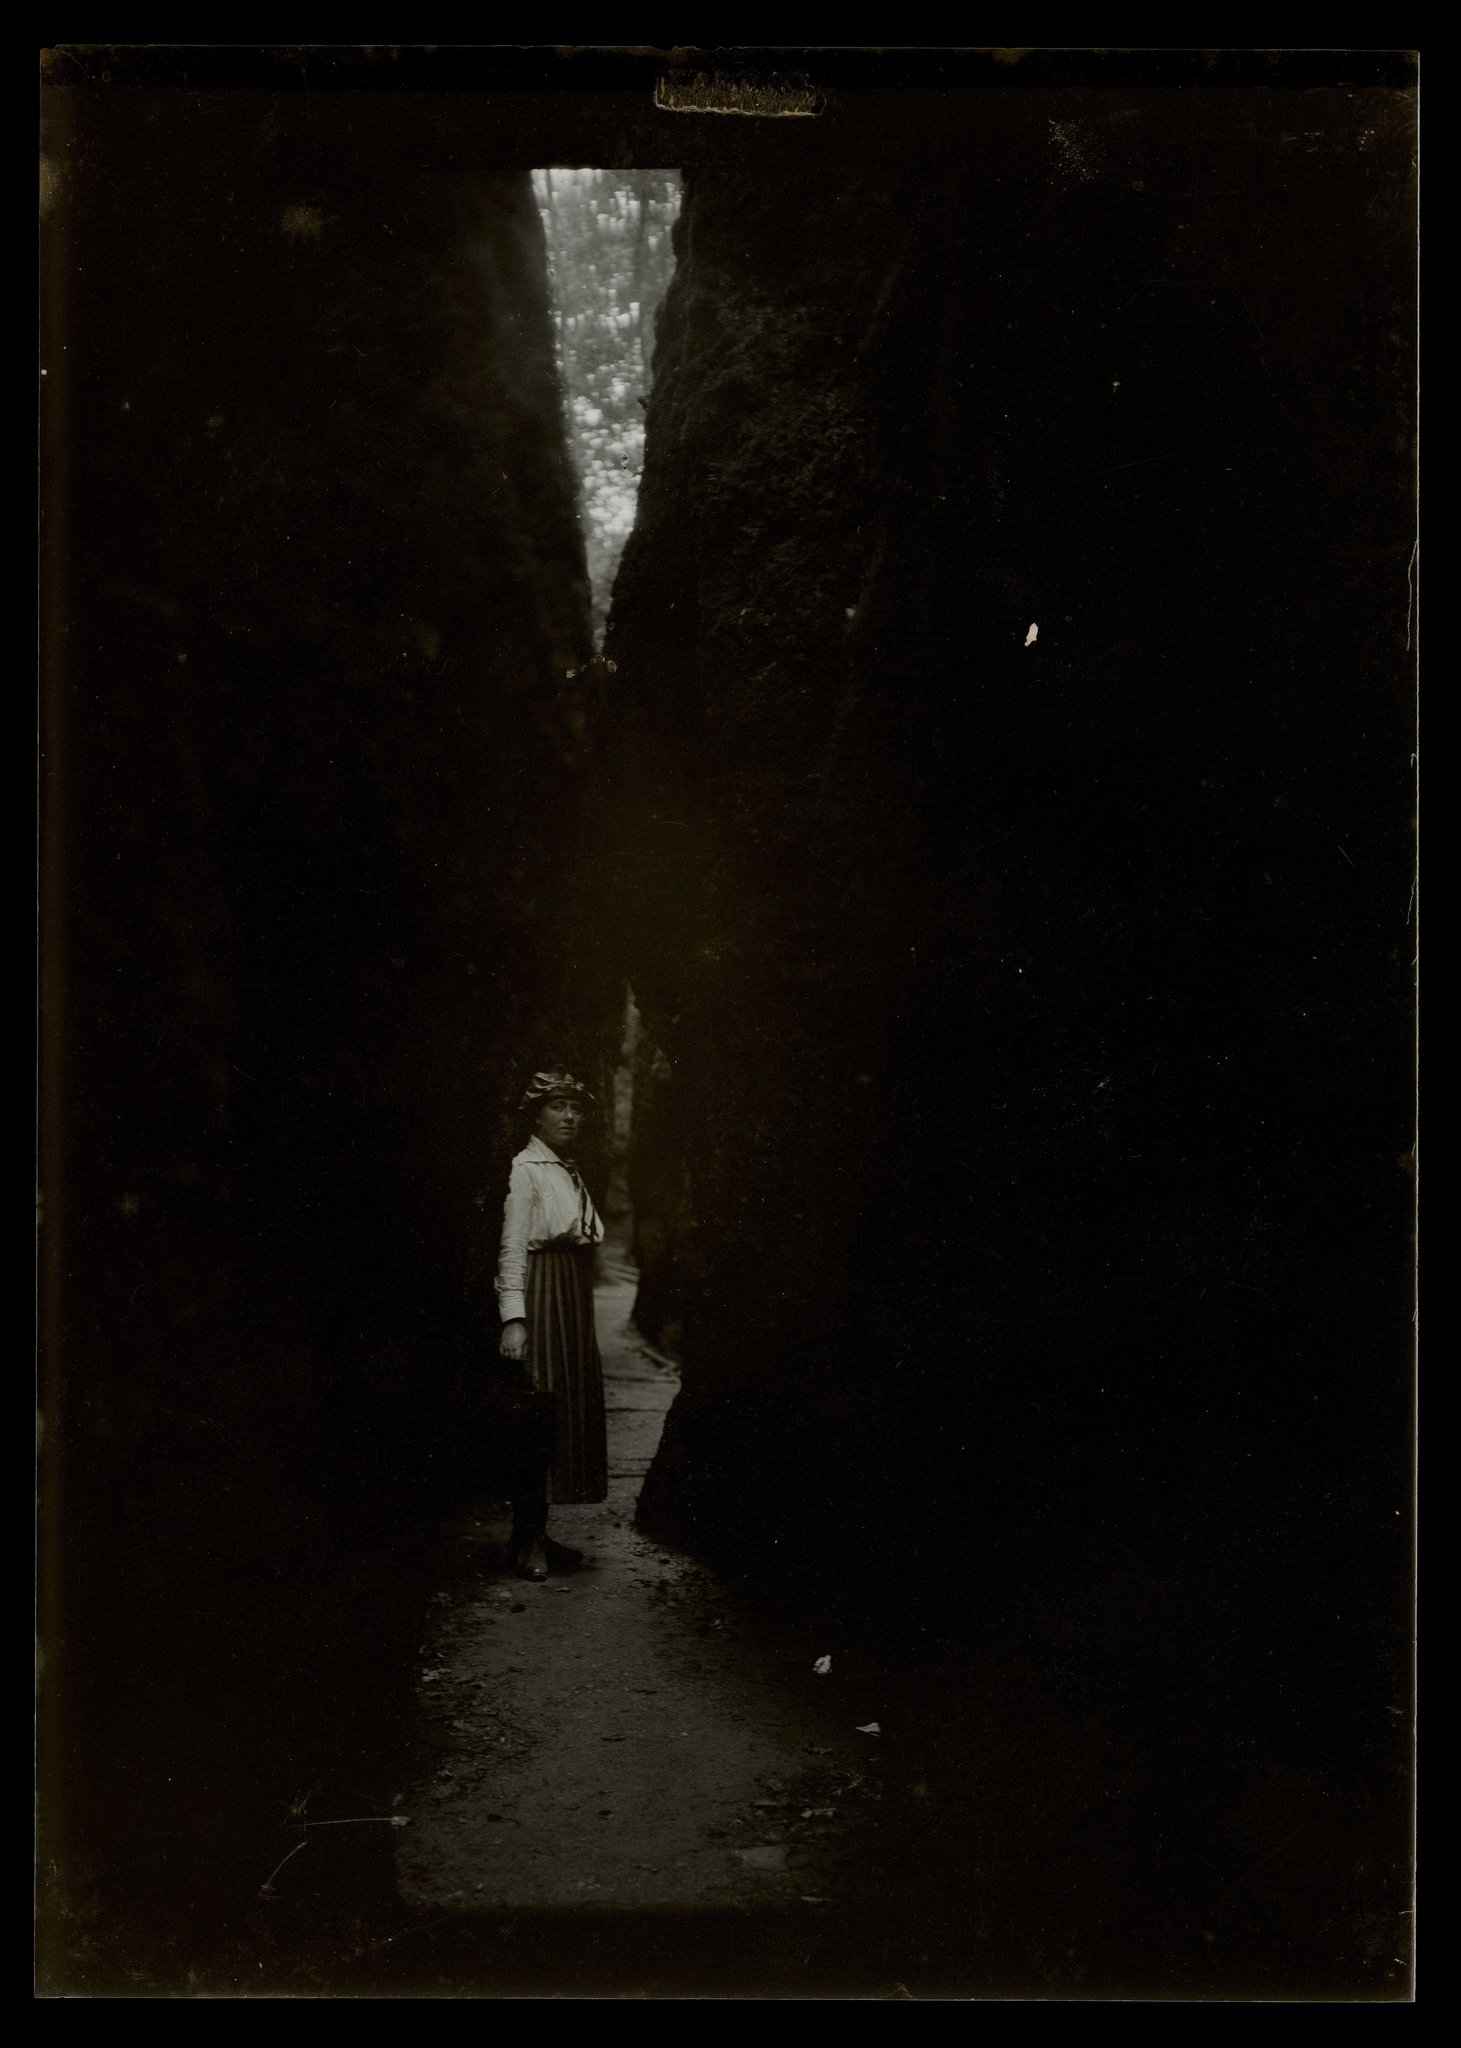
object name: photograph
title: Filmnegatief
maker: Anonymous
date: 1907-1935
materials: film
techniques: gelatin silver negative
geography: europe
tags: europe